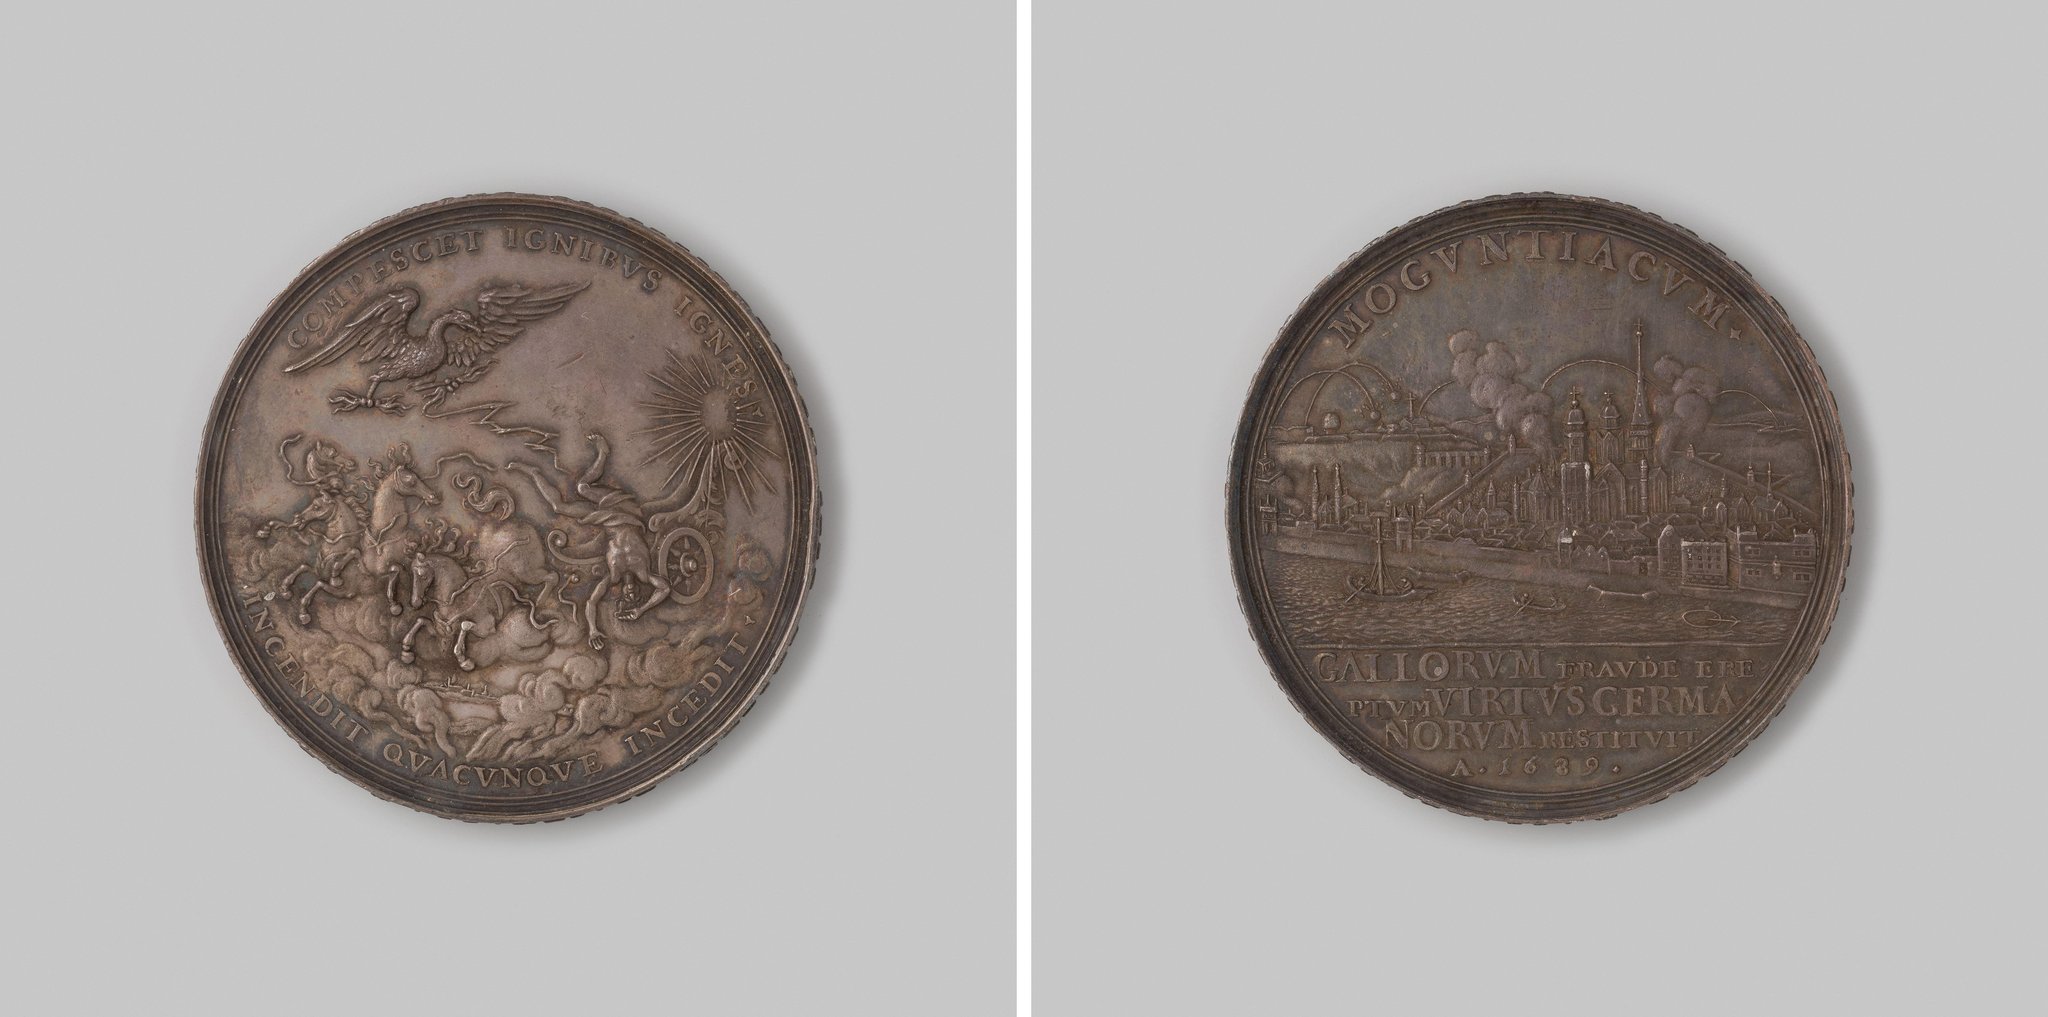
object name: history medal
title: Inname van Mainz door de keizerlijken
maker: Anonymous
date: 1689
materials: silver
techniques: striking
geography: germany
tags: mainz, rijnland-palts, inname van mainz, negenjarige oorlog